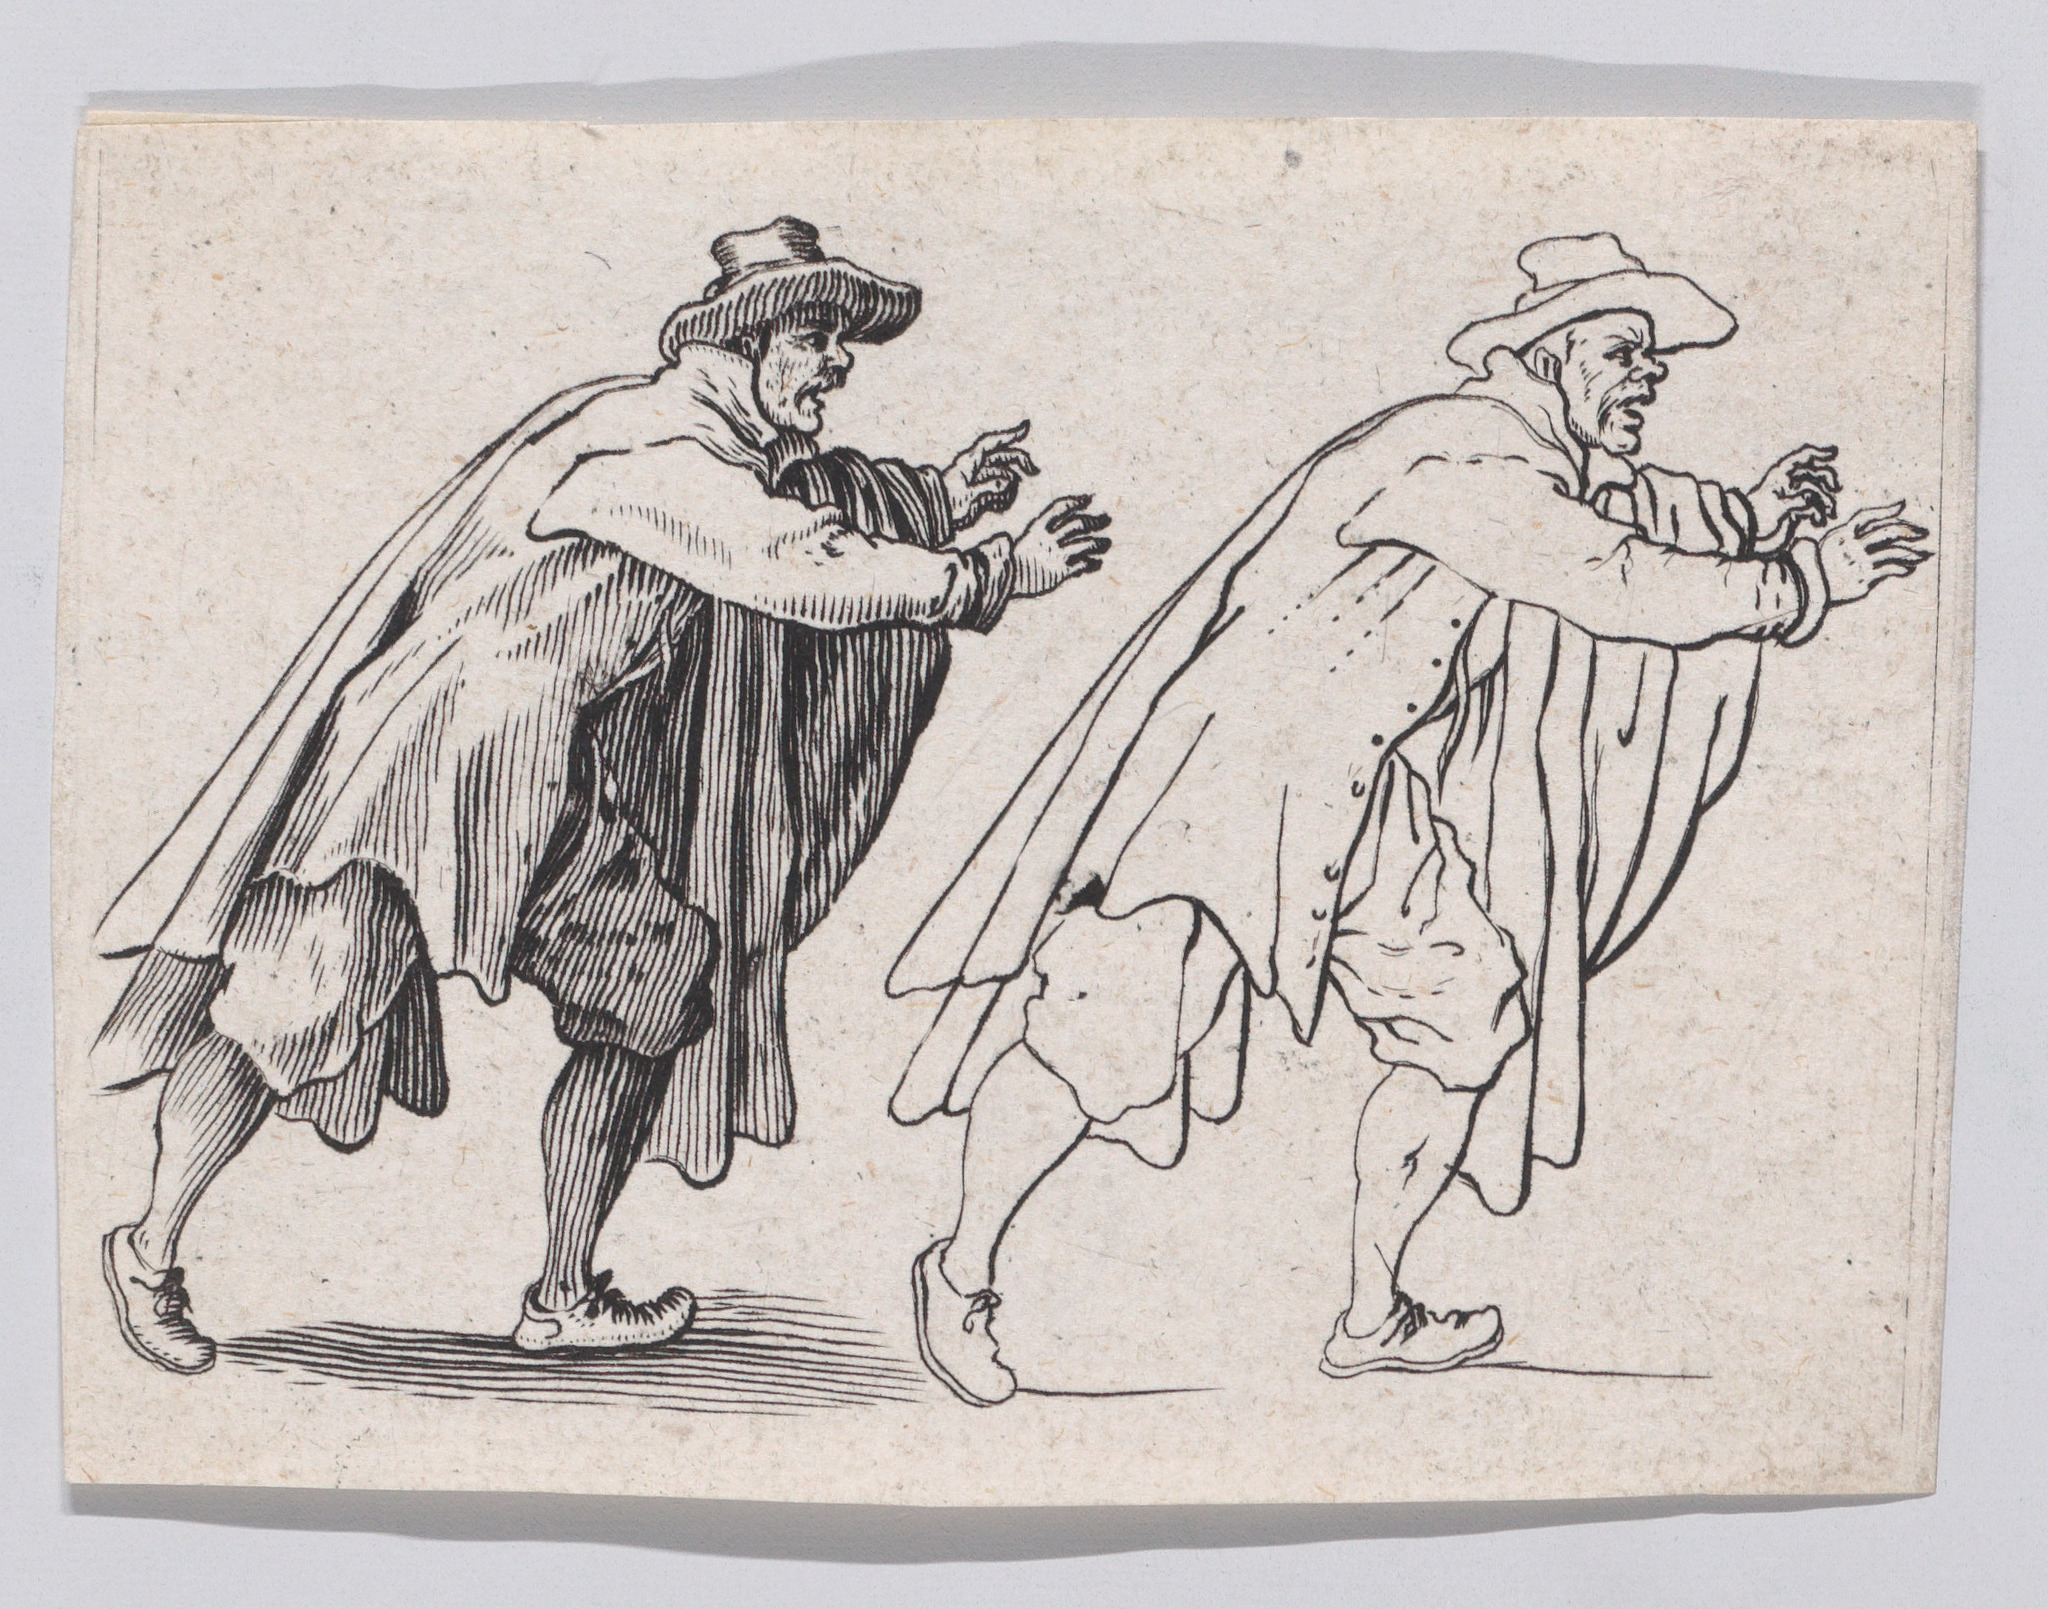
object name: print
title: Copy of L'Homme Qui Court (The Running Man), from "Les Caprices" Series B, The Nancy Set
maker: Anonymous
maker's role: artist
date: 1601-1700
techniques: etching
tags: men